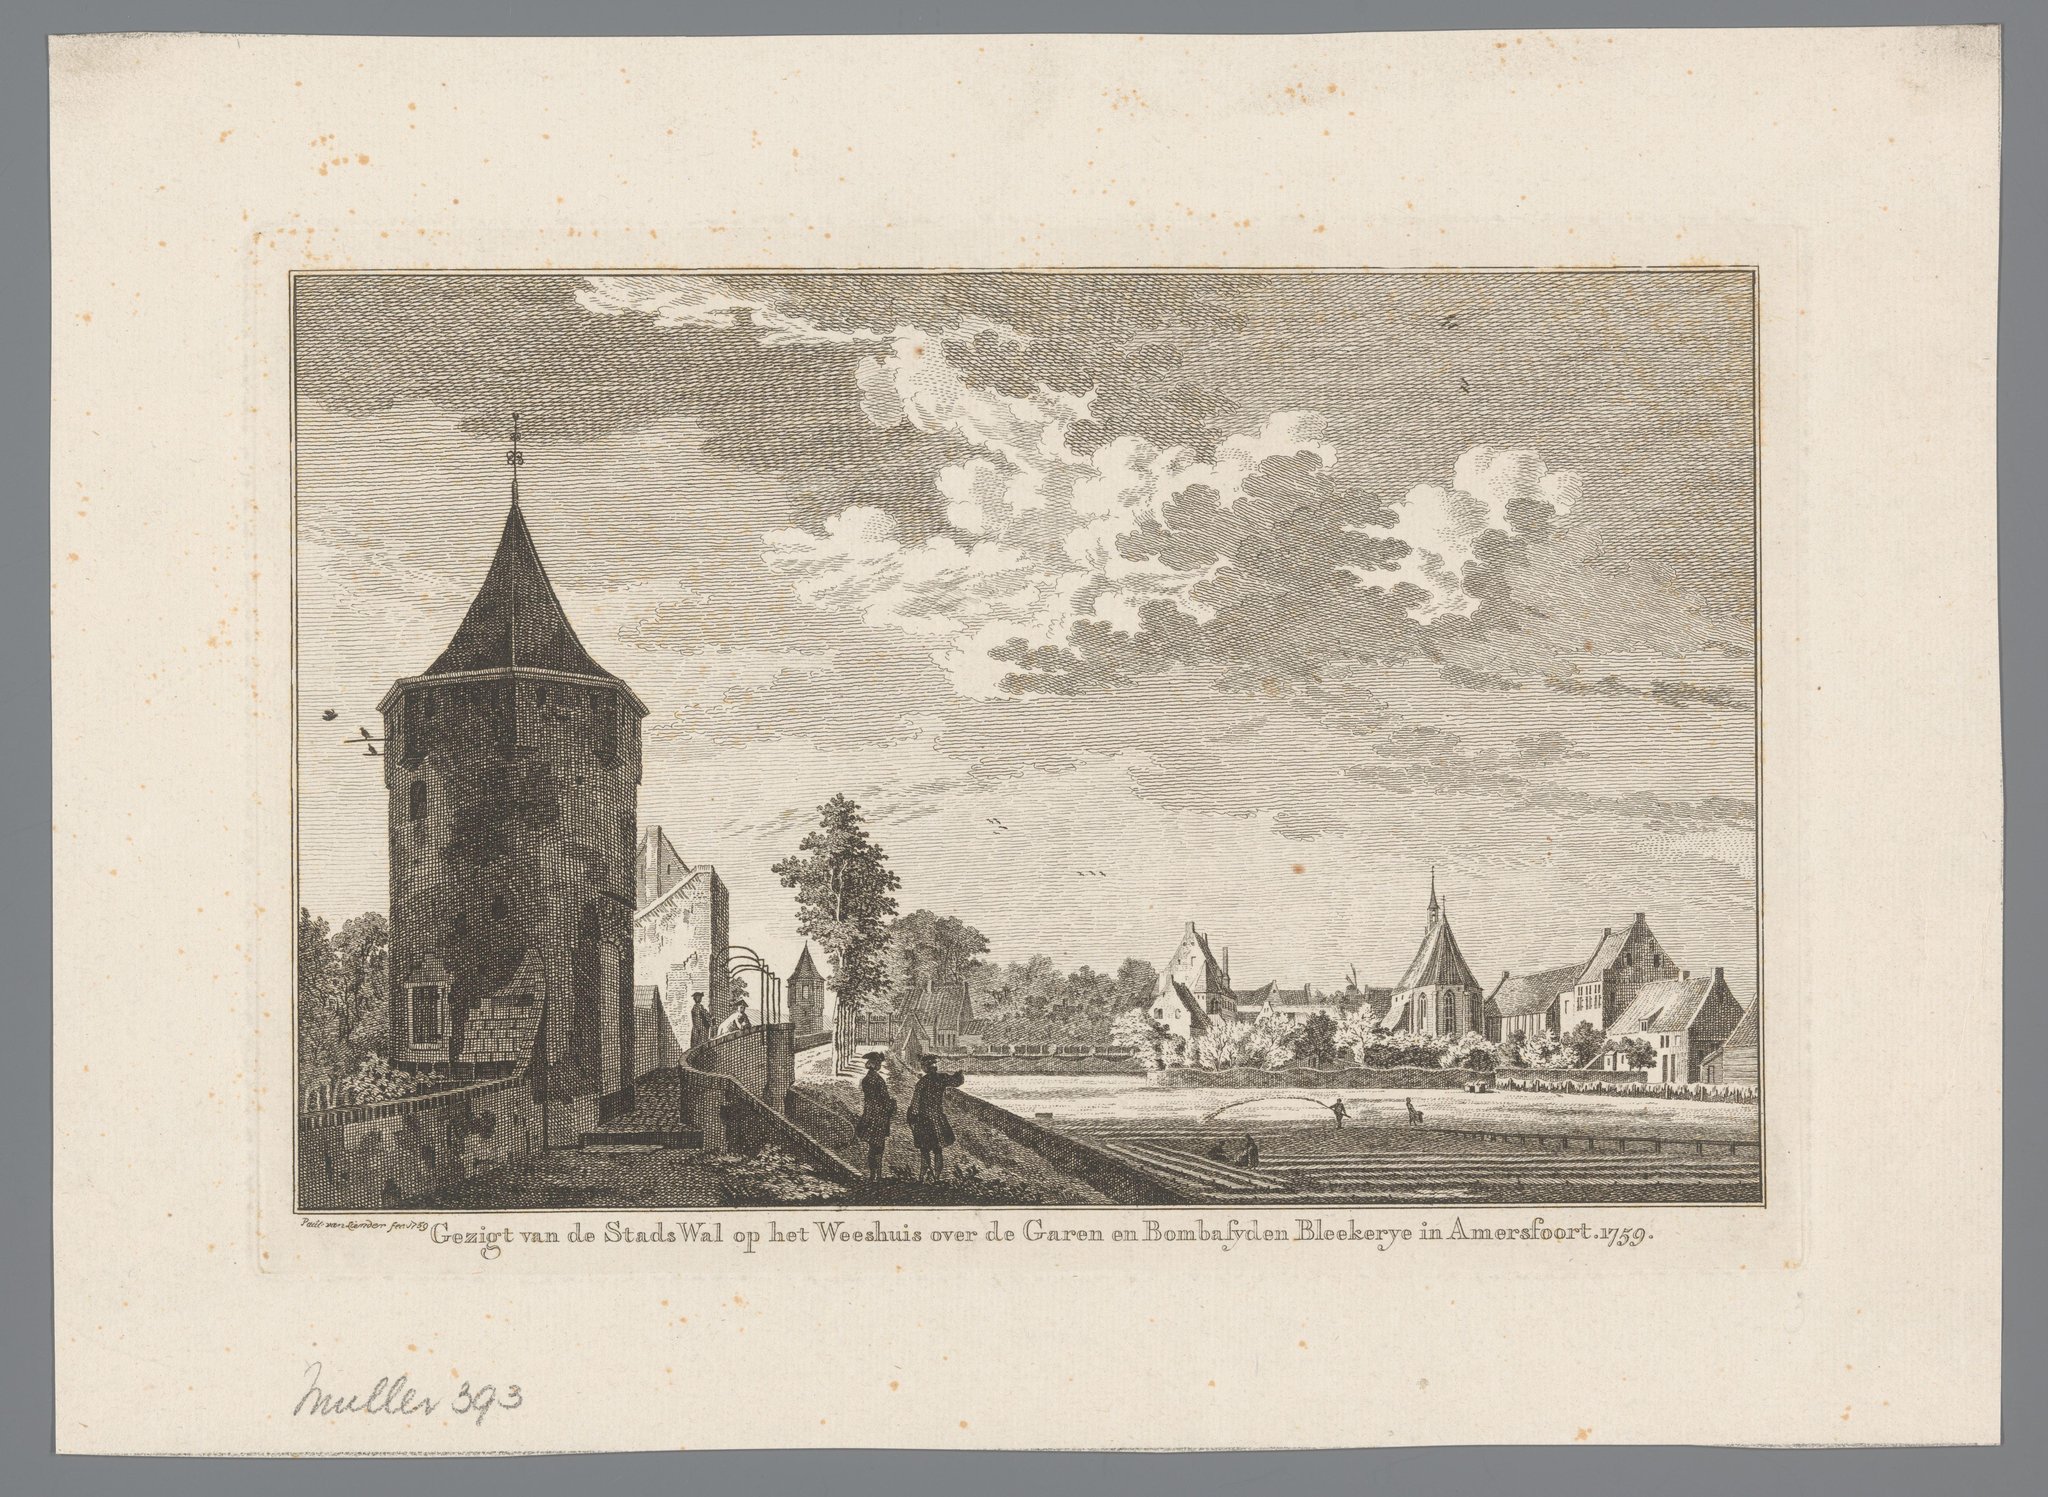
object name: book illustration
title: Gezicht op het weeshuis en blekerij bij Amersfoort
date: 1760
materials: paper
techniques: engraving, etching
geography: utrecht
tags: bleaching (laundering), orphanage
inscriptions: collector's mark: Lugt 2228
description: Prent uit: Bemmel, Abraham van. Beschryving der stad Amersfoort (...). 2 dln. Utrecht: Henricus Spruyt, 1760.